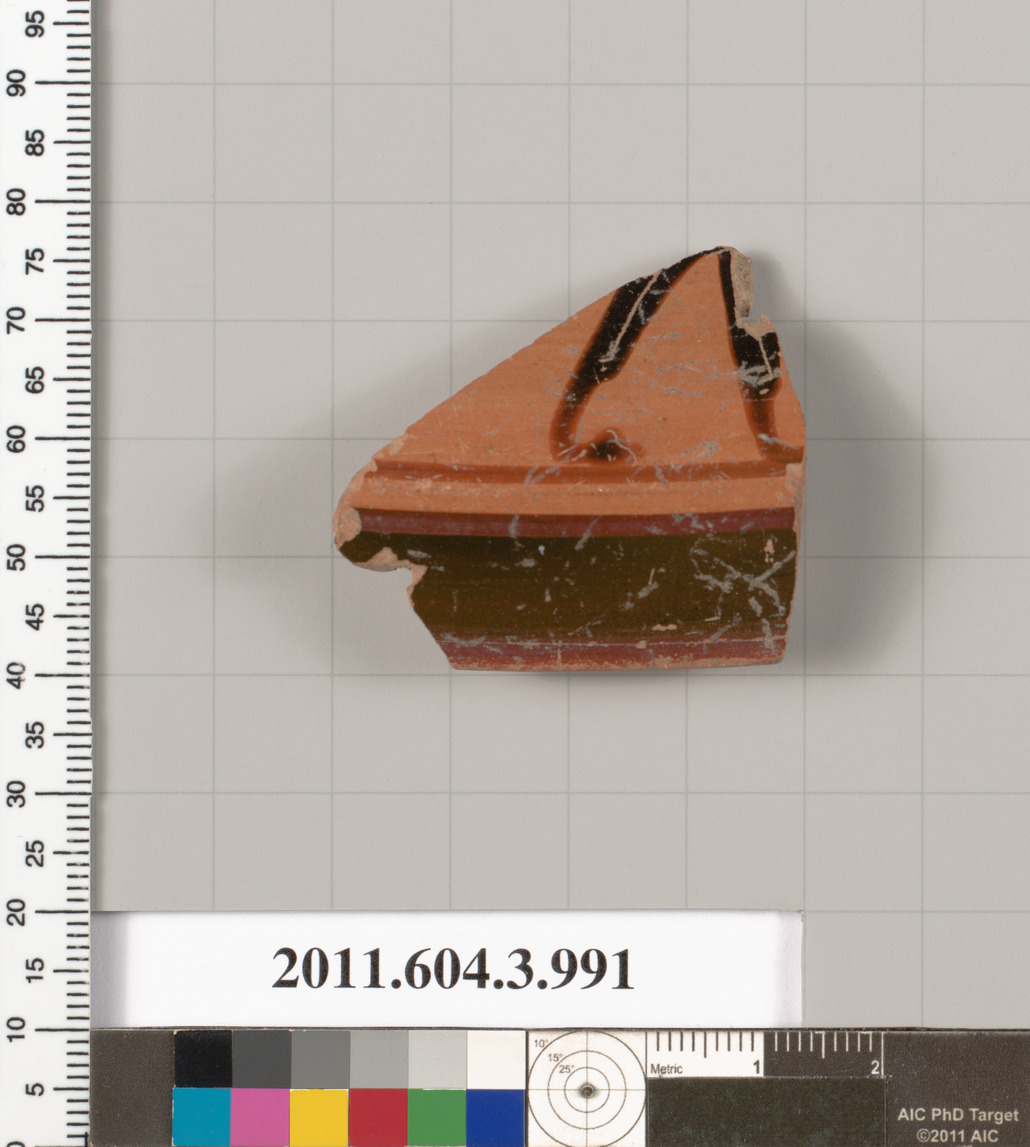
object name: lekanis lid fragment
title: Terracotta fragment of a lekanis lid (covered dish)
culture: greek, attic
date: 575-551 BCE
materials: terracotta